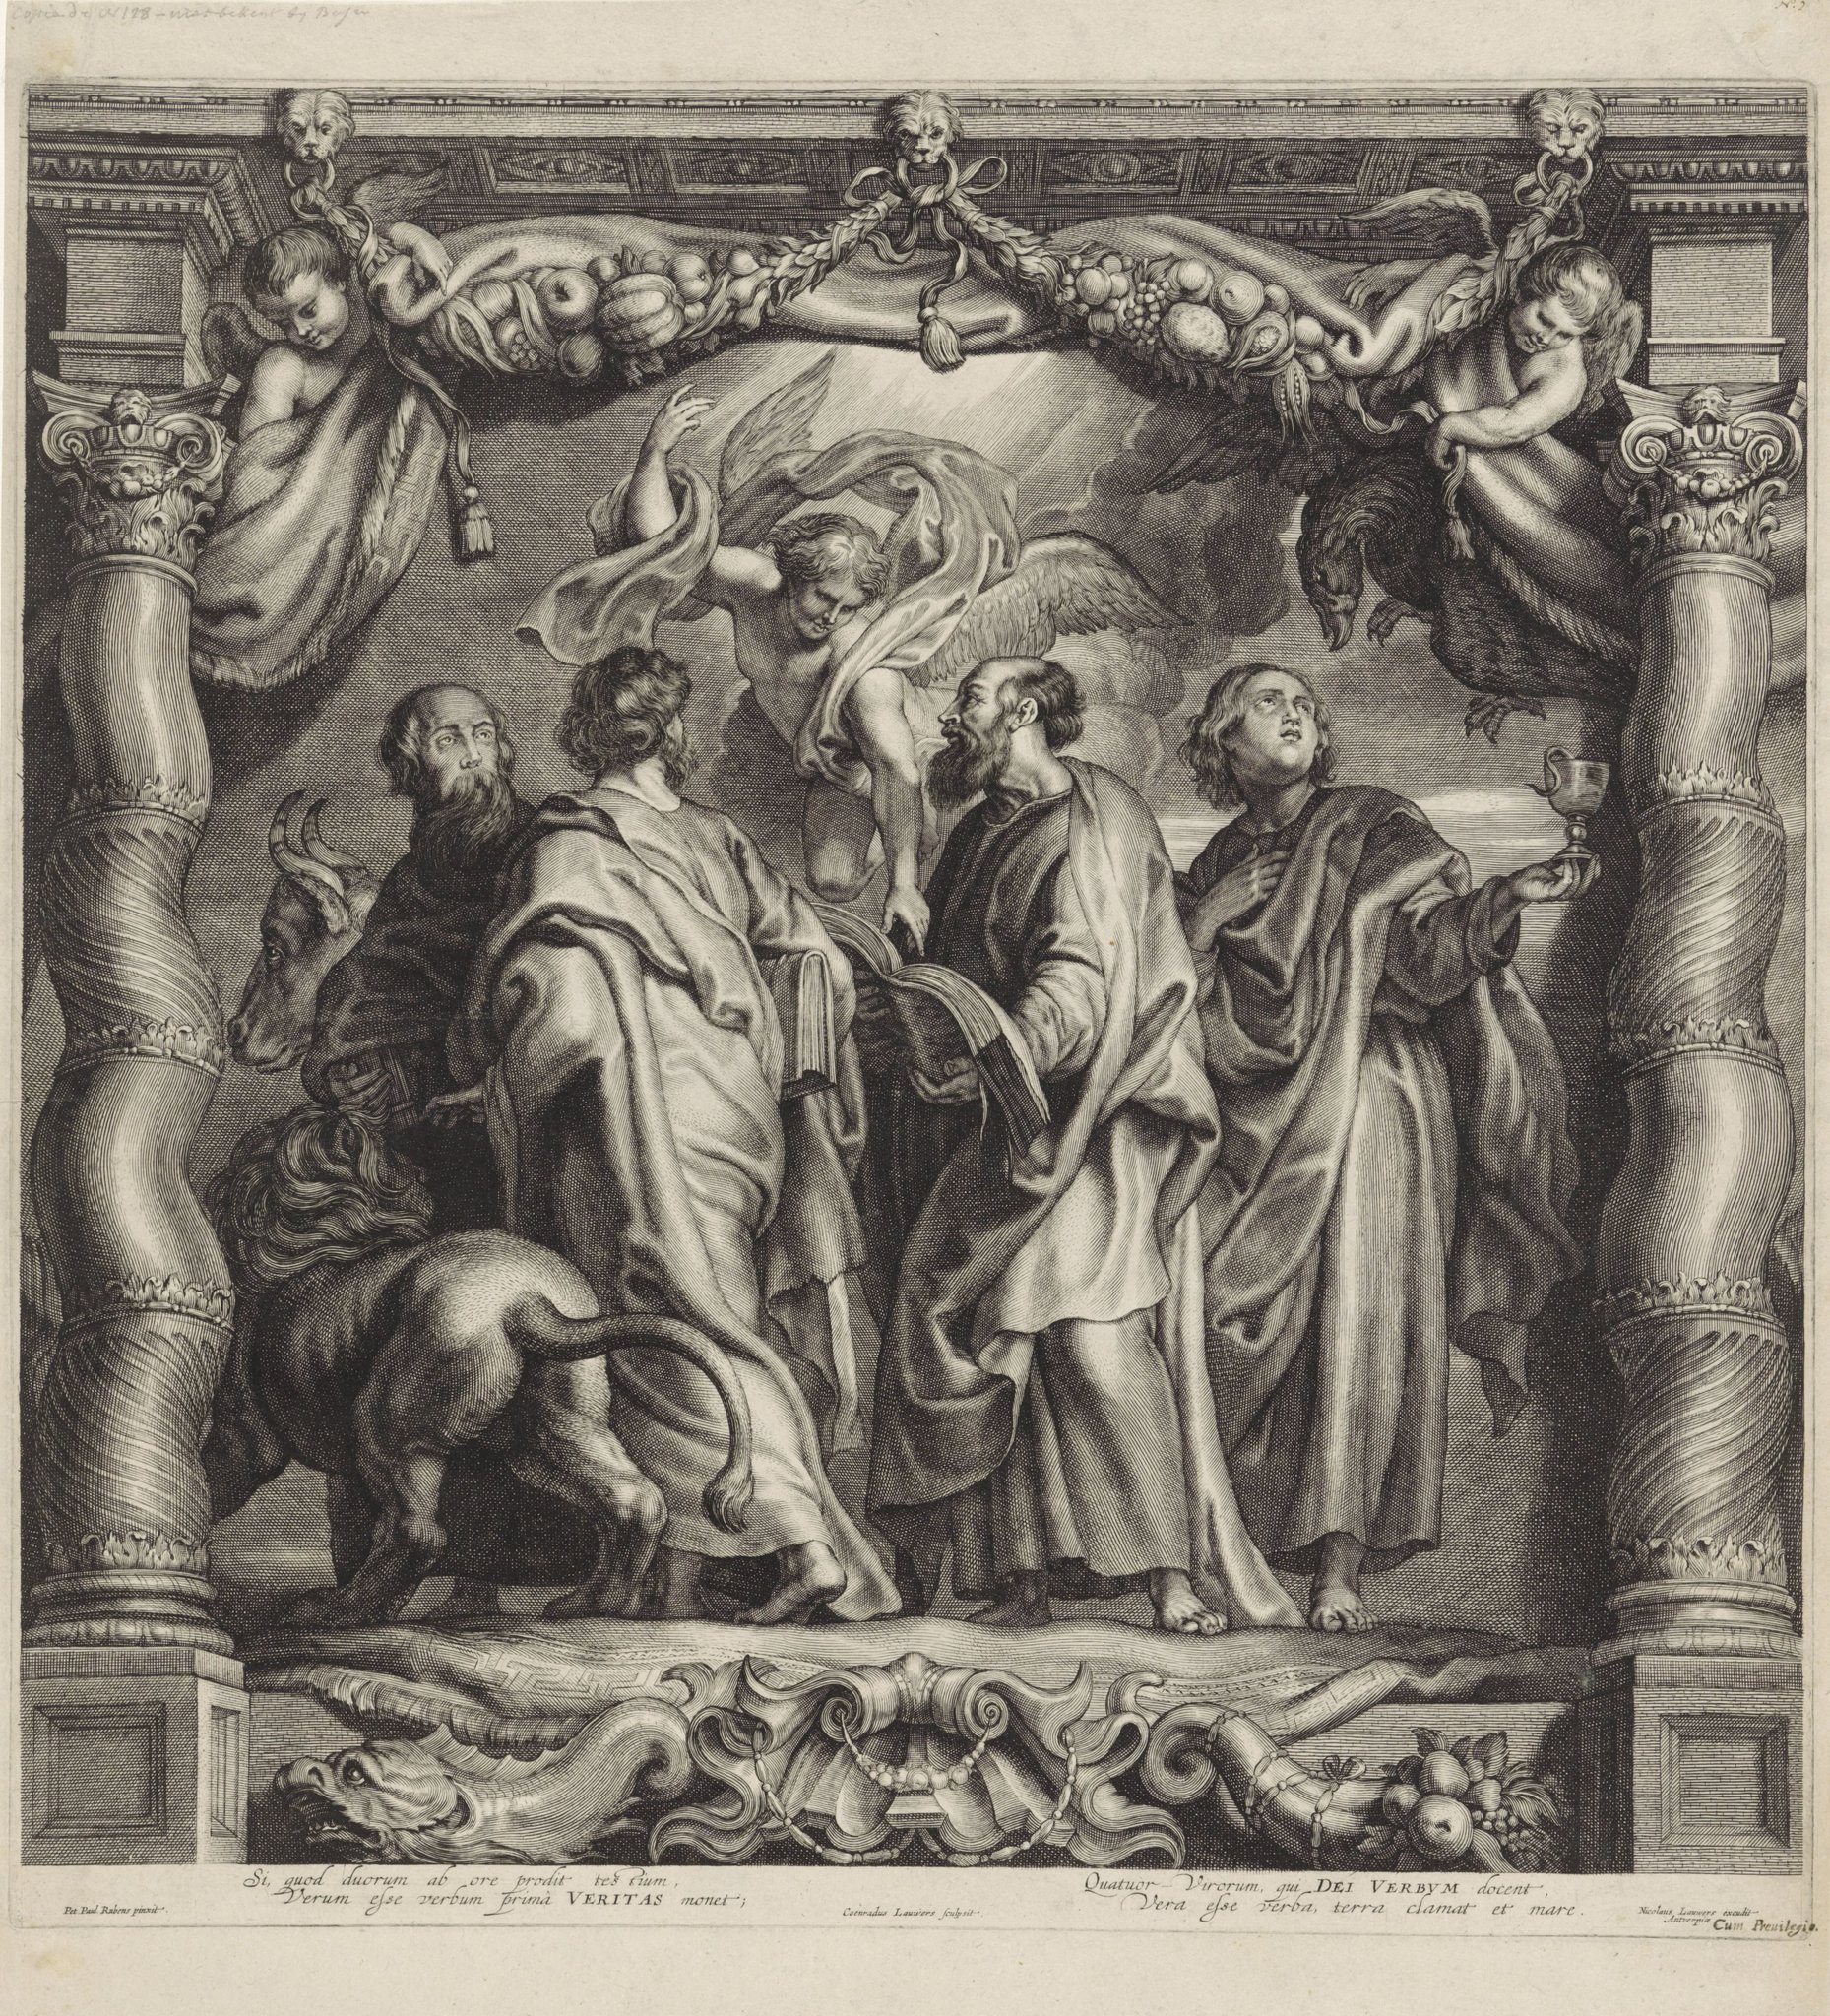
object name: print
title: De vier evangelisten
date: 1642-1652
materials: paper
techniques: engraving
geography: antwerp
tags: the four evangelists ~ the four main prophets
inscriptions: collector's mark: Lugt 240, collector's mark: Lugt 2228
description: De vier evangelisten met hun attributen in een architecturale setting.